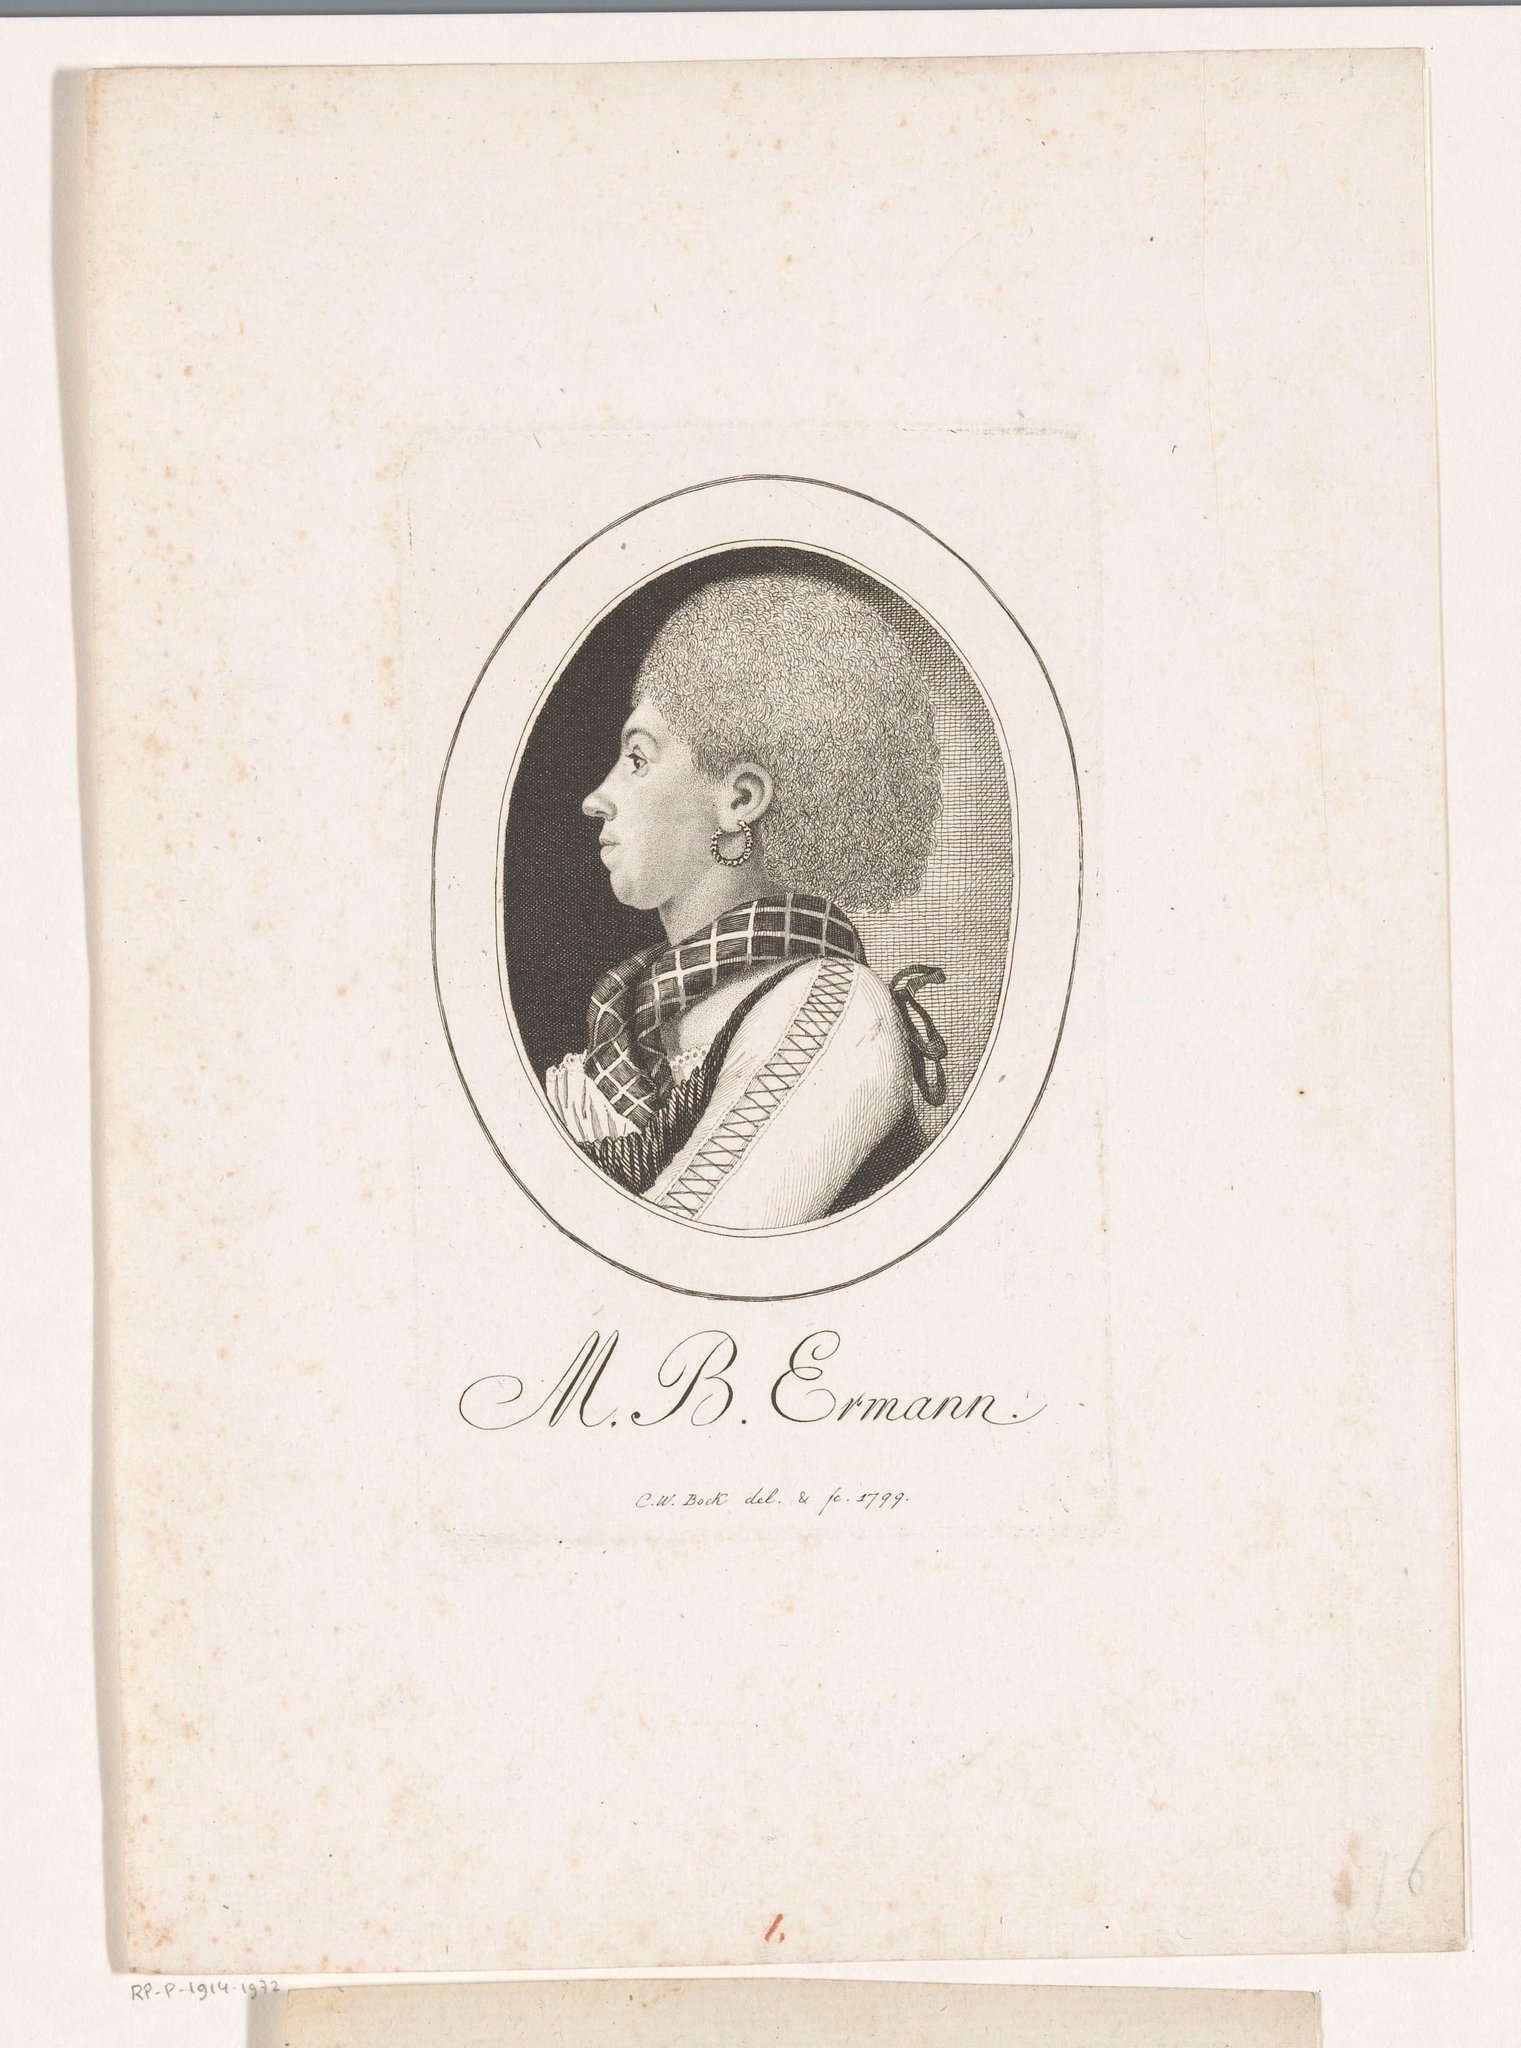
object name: print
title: Portret van Margaretha Barbara Ermann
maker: christoph wilhelm bock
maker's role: print maker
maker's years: 1755-1836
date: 1799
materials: paper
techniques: engraving, etching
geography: nuremberg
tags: historical persons - bb - woman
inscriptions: collector's mark: Lugt 2228